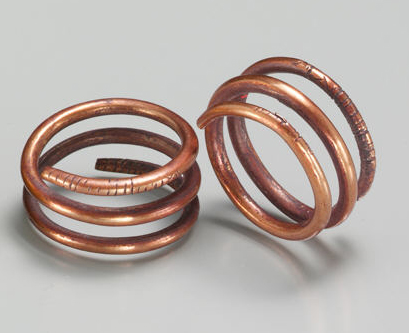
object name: earring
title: Pair of Sprial Earrings (with 16.10.469)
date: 1635-1458 BCE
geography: egypt